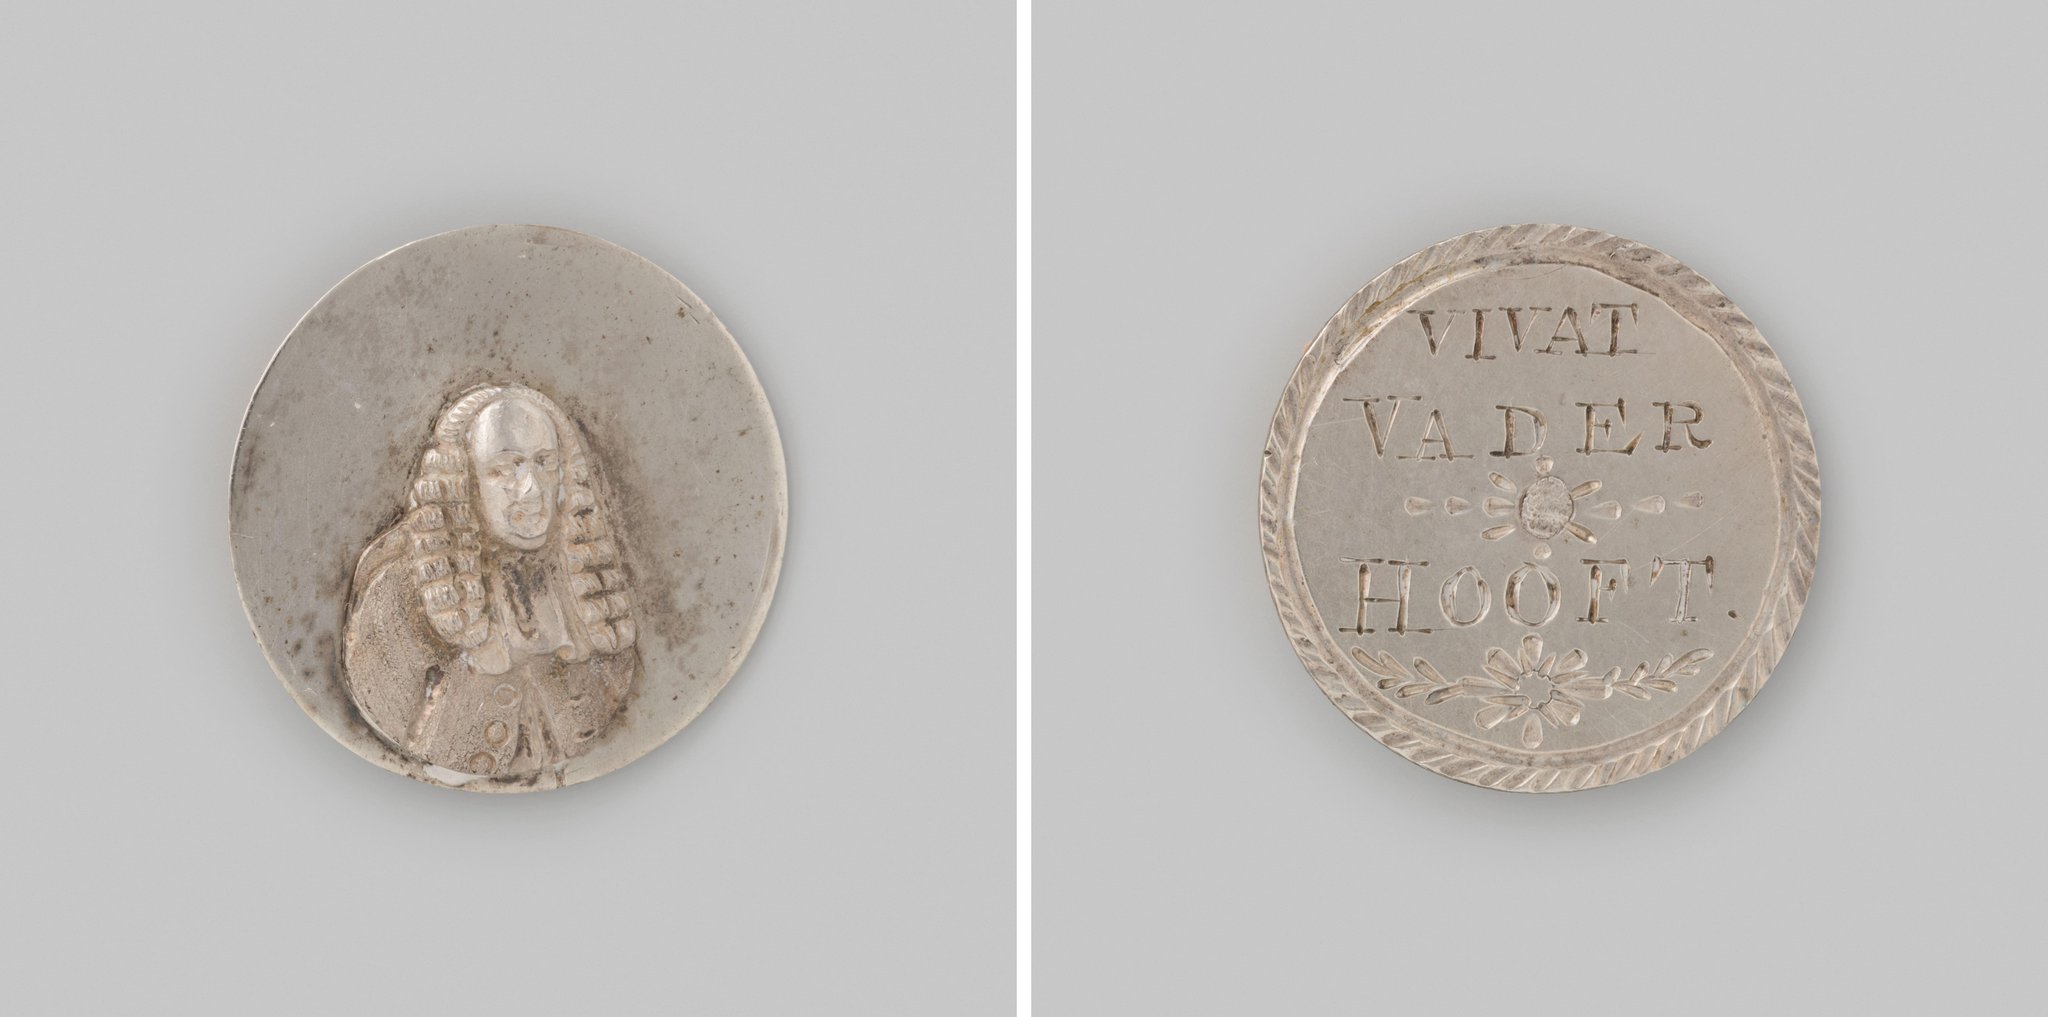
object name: insignia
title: Hendrik Danielsz. Hooft, burgemeester van Amsterdam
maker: Anonymous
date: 1787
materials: silver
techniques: engraving, fastening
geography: netherlands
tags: amsterdam, mayor, hendrik danielsz. hooft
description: Zilveren penning. Voorzijde: borststuk man. Keerzijde: opschrift met daartussen sierornamenten binnen gearceerde rand